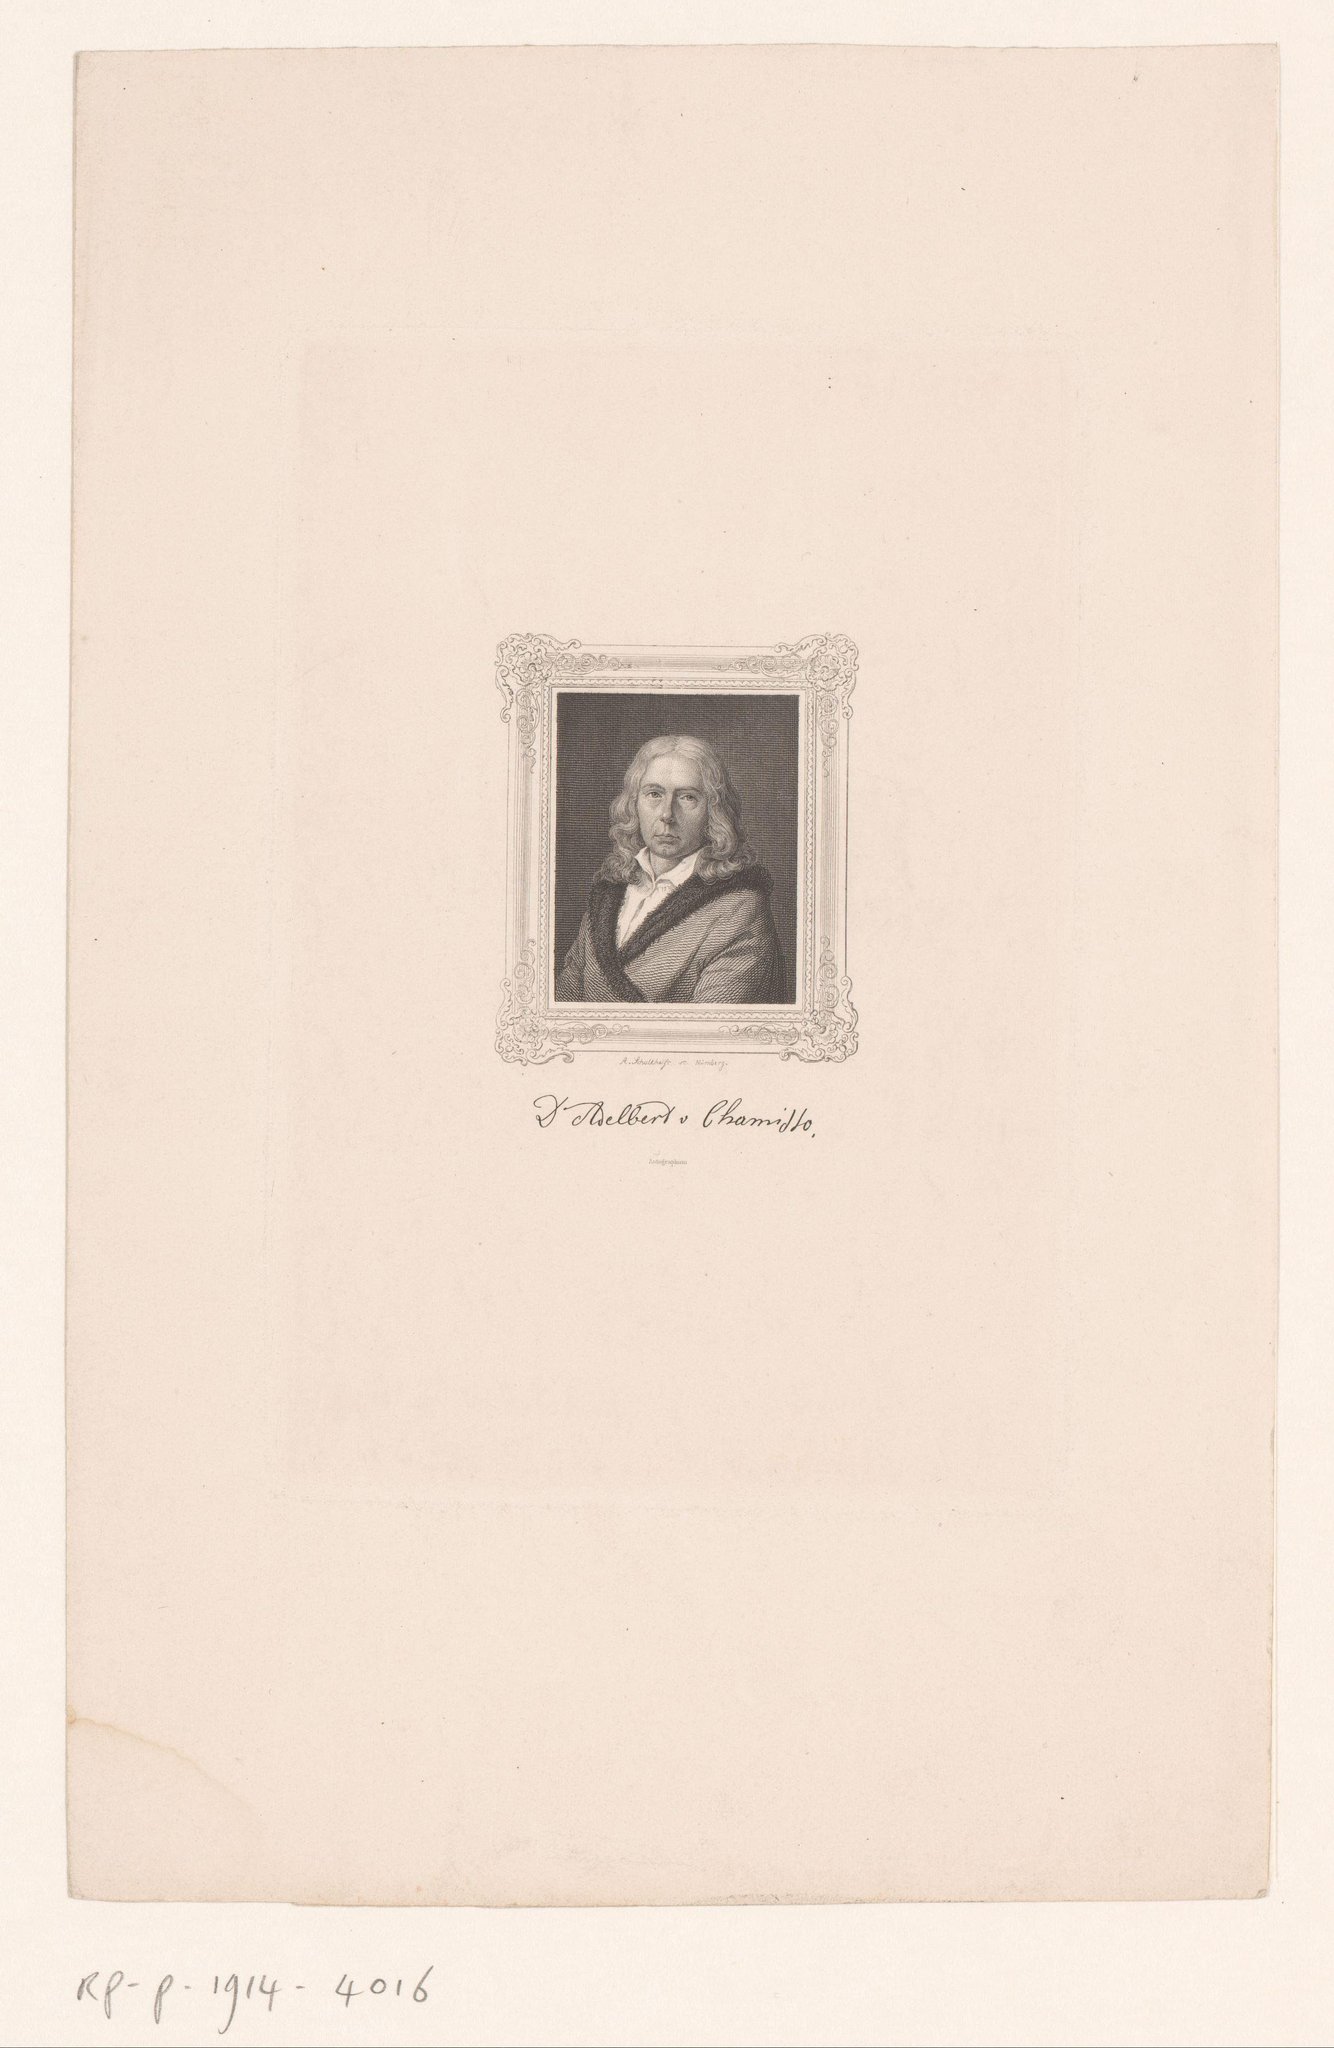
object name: print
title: Portret van Adelbert von Chamisso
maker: albrecht schultheiss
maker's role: print maker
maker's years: 1823-1909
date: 1833-1909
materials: paper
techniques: engraving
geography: nuremberg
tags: adelbert von chamisso, historical persons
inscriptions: collector's mark: Lugt 2228